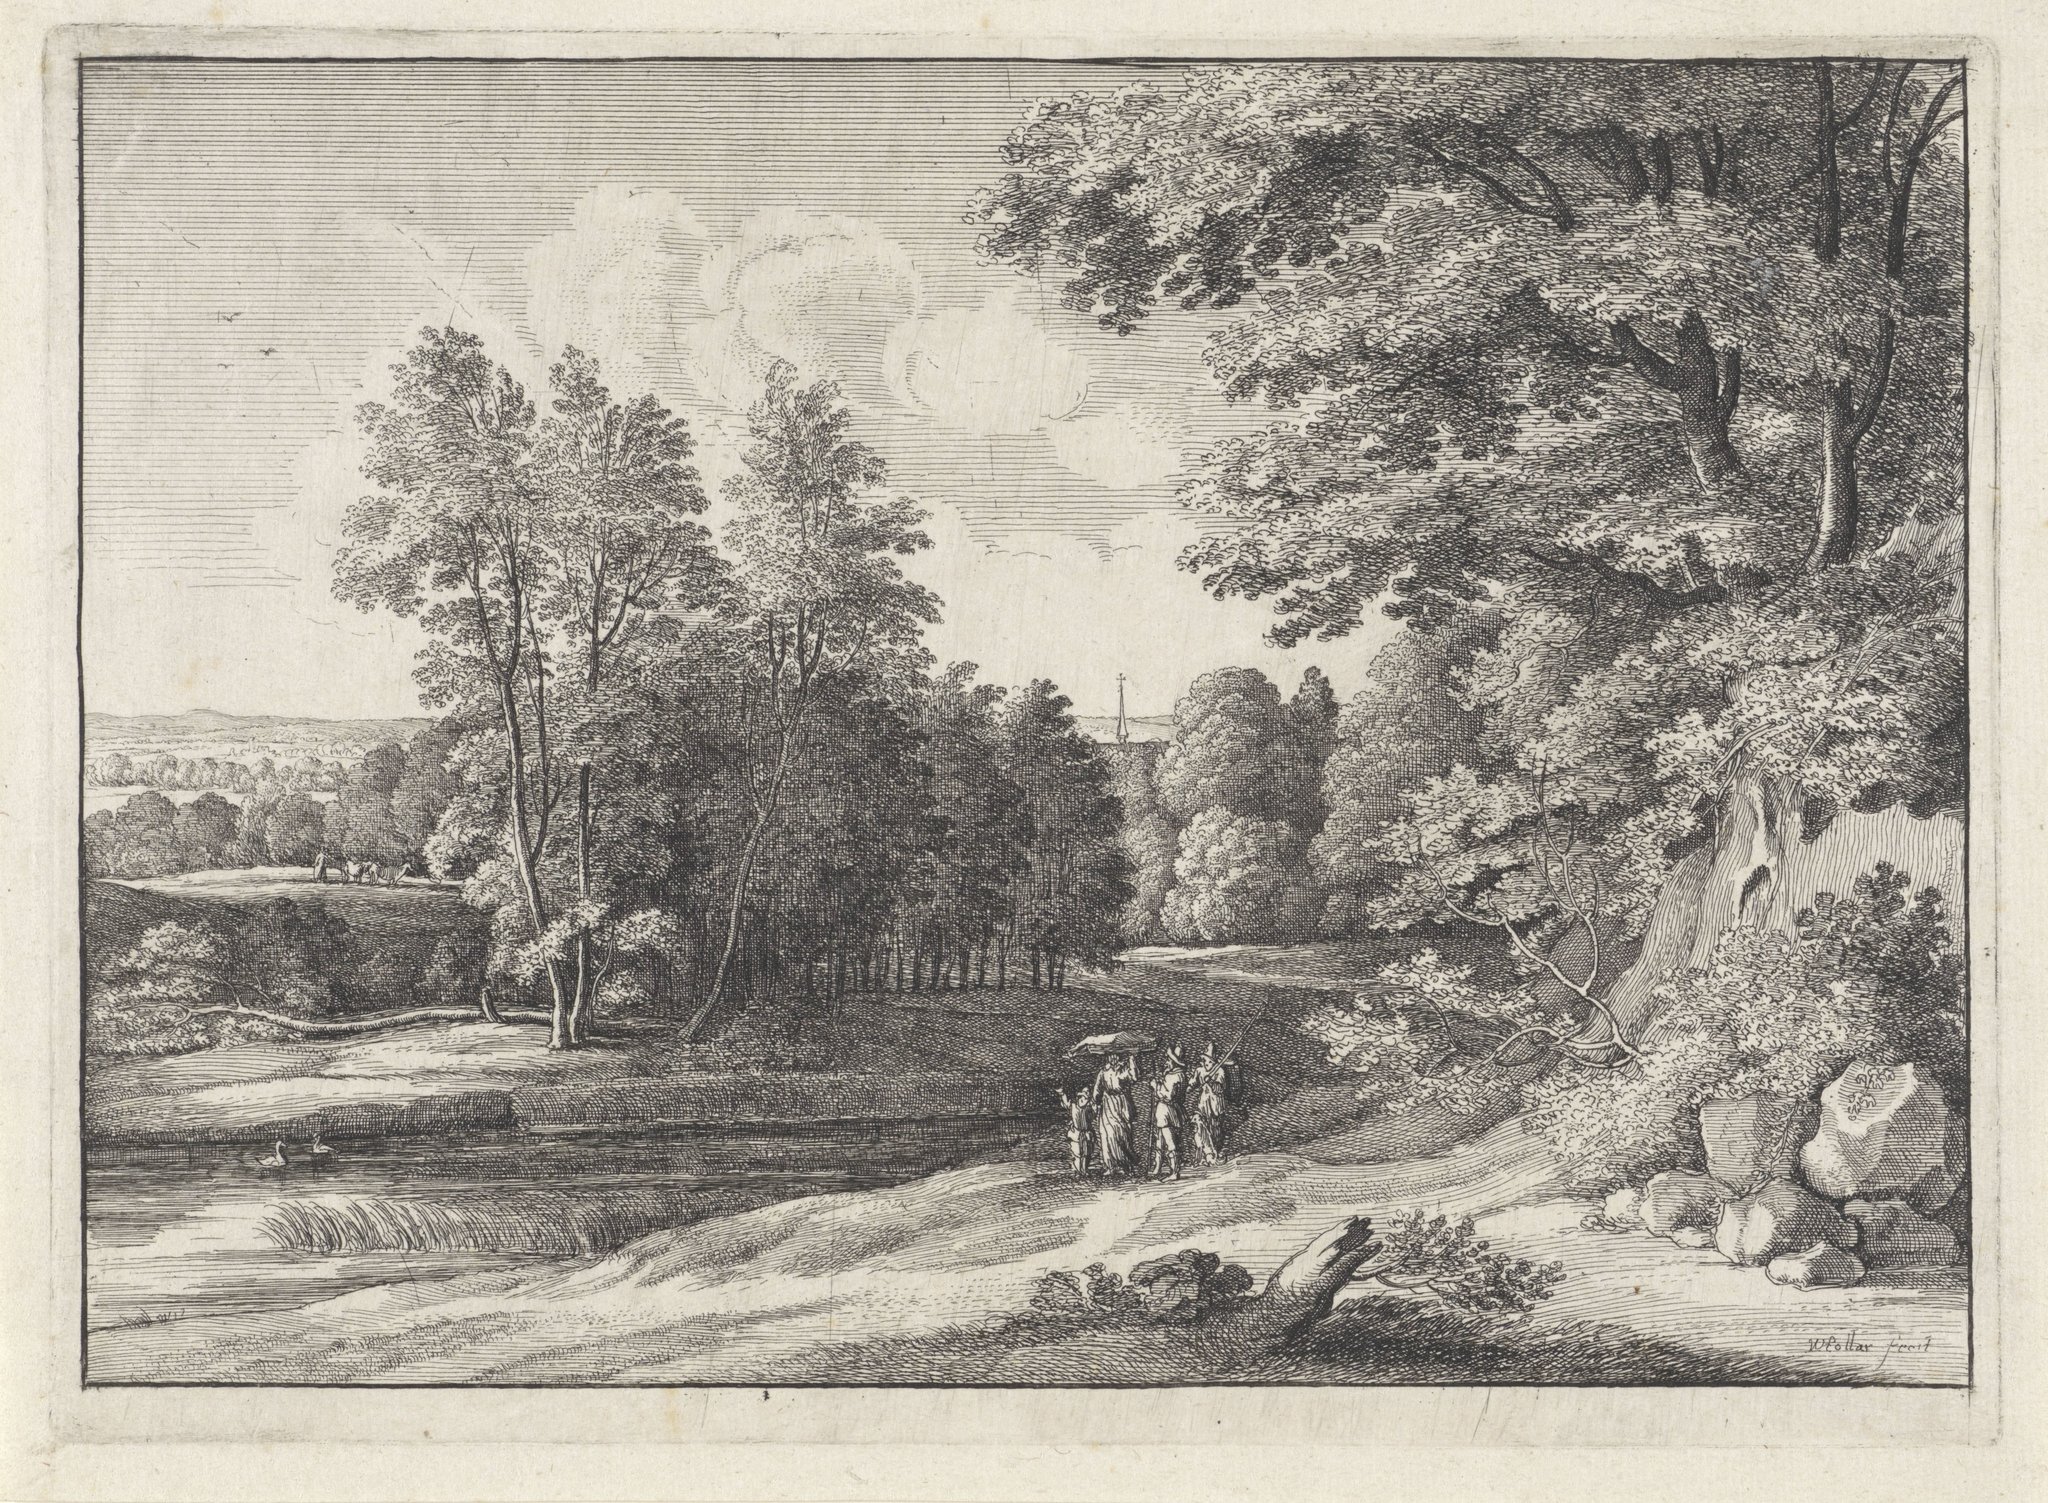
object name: print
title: Landschap met figuren bij een meertje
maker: wenceslaus hollar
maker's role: draughtsman, print maker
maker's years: 1607-1677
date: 1648-1650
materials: paper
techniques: drypoint, etching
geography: antwerp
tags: landscapes with waters, waterscapes, seascapes (in the temperate zone)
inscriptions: collector's mark: Lugt 240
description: De prent maakt deel uit van een zevendelige serie met landschappen naar Jacques d'Arthois (ongenummerd).